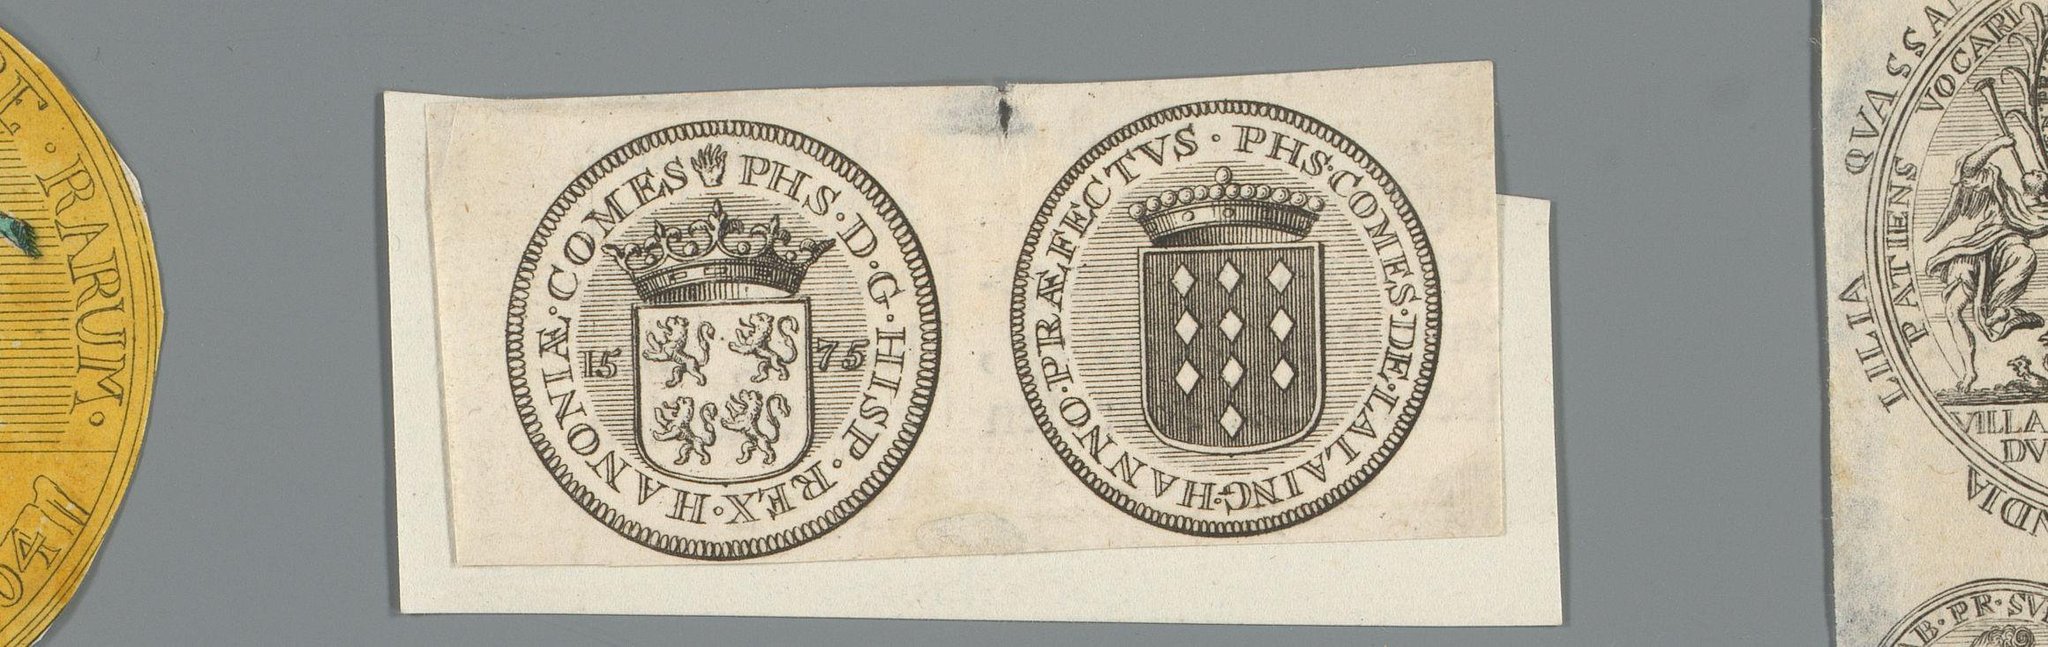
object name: book illustration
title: Voor- en achterzijde van een penning met het wapen van Henegouwen en van Filips van Lalaing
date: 1723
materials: paper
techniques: etching, letterpress printing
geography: the hague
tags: coat of arms (symbol of sovereignty), historical persons, coin, ruler, sovereign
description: Prent uit: Loon, Gerard van. Beschryving der Nederlandsche Historipenningen: (...). Den Haag: Christiaan van Lom et al., 1723, dl. 1, p. 276.